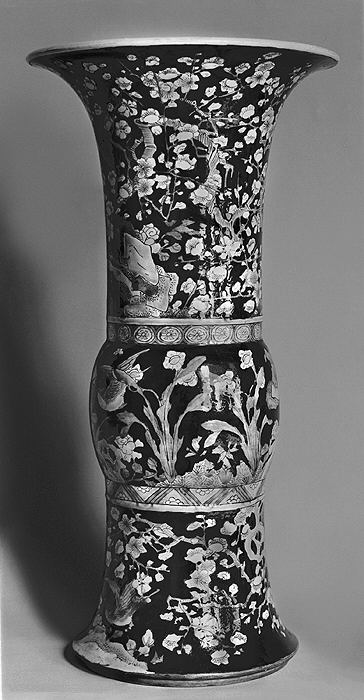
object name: vase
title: Vase with birds and flowers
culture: chinese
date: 1801-1900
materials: enamel, porcelain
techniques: painting, polychrome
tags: flowers